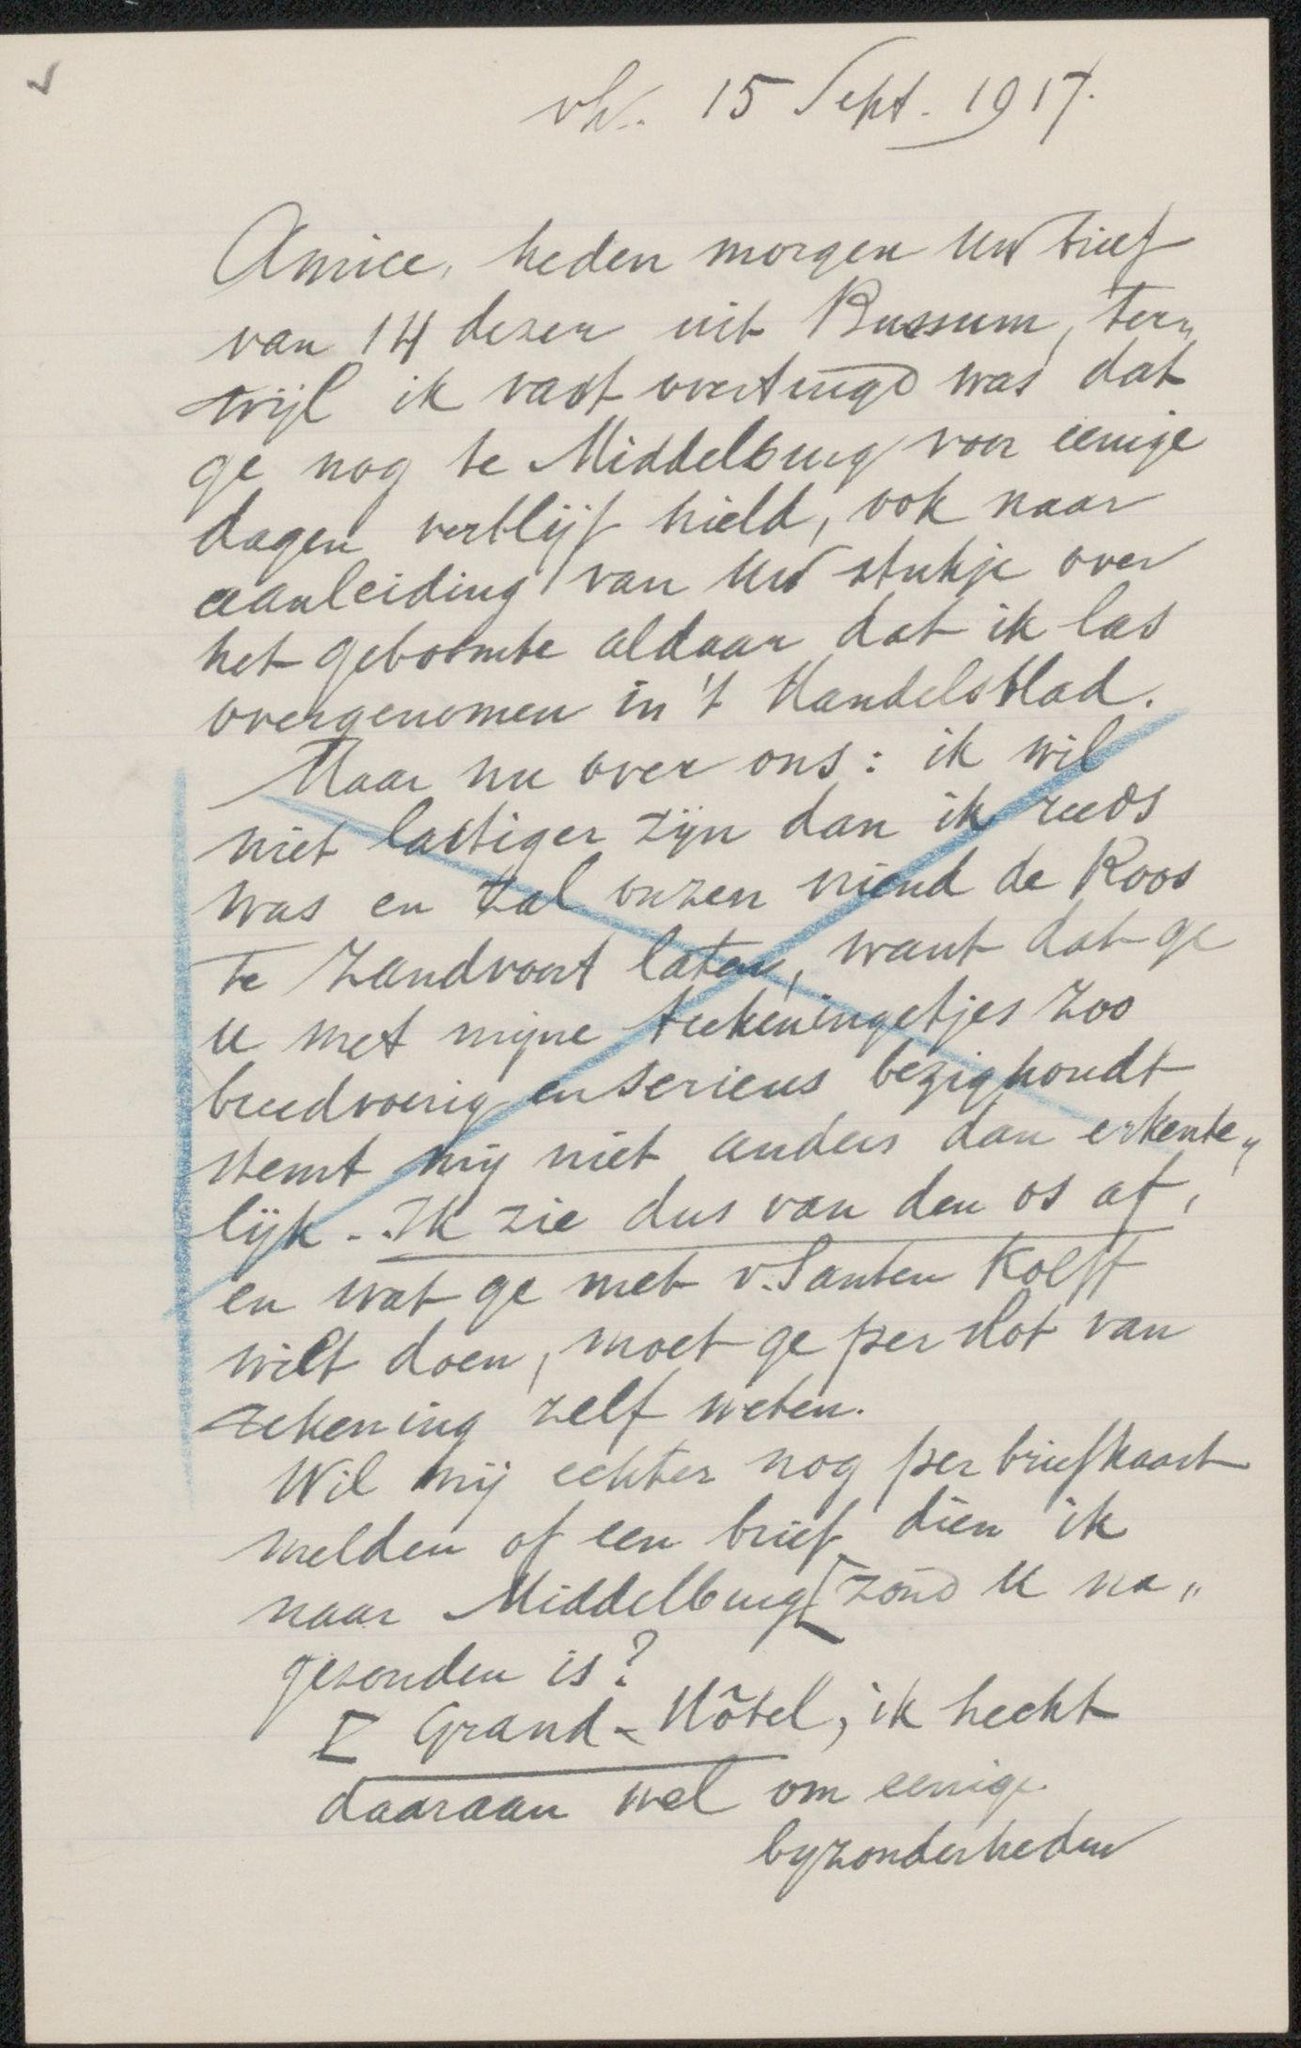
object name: letter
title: Brief aan Jan Veth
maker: august allebé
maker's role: draughtsman, print maker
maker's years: 1838-1927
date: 1917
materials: ink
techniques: pen, writing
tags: thomas simon cool, paris, eugène delacroix, dordrecht, jan veth, philip sadée, utrecht, arnhem, painter, print maker, draughtsman, willem de famars testas, haarlem, sjoerd hendrik de roos, taco jan scheltema, johan gram, jacobus everhardus josephus van den berg, rotterdam, criticizing and discussing art, art criticism, drawing, middelburg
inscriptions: collector's mark: ‘RPK’